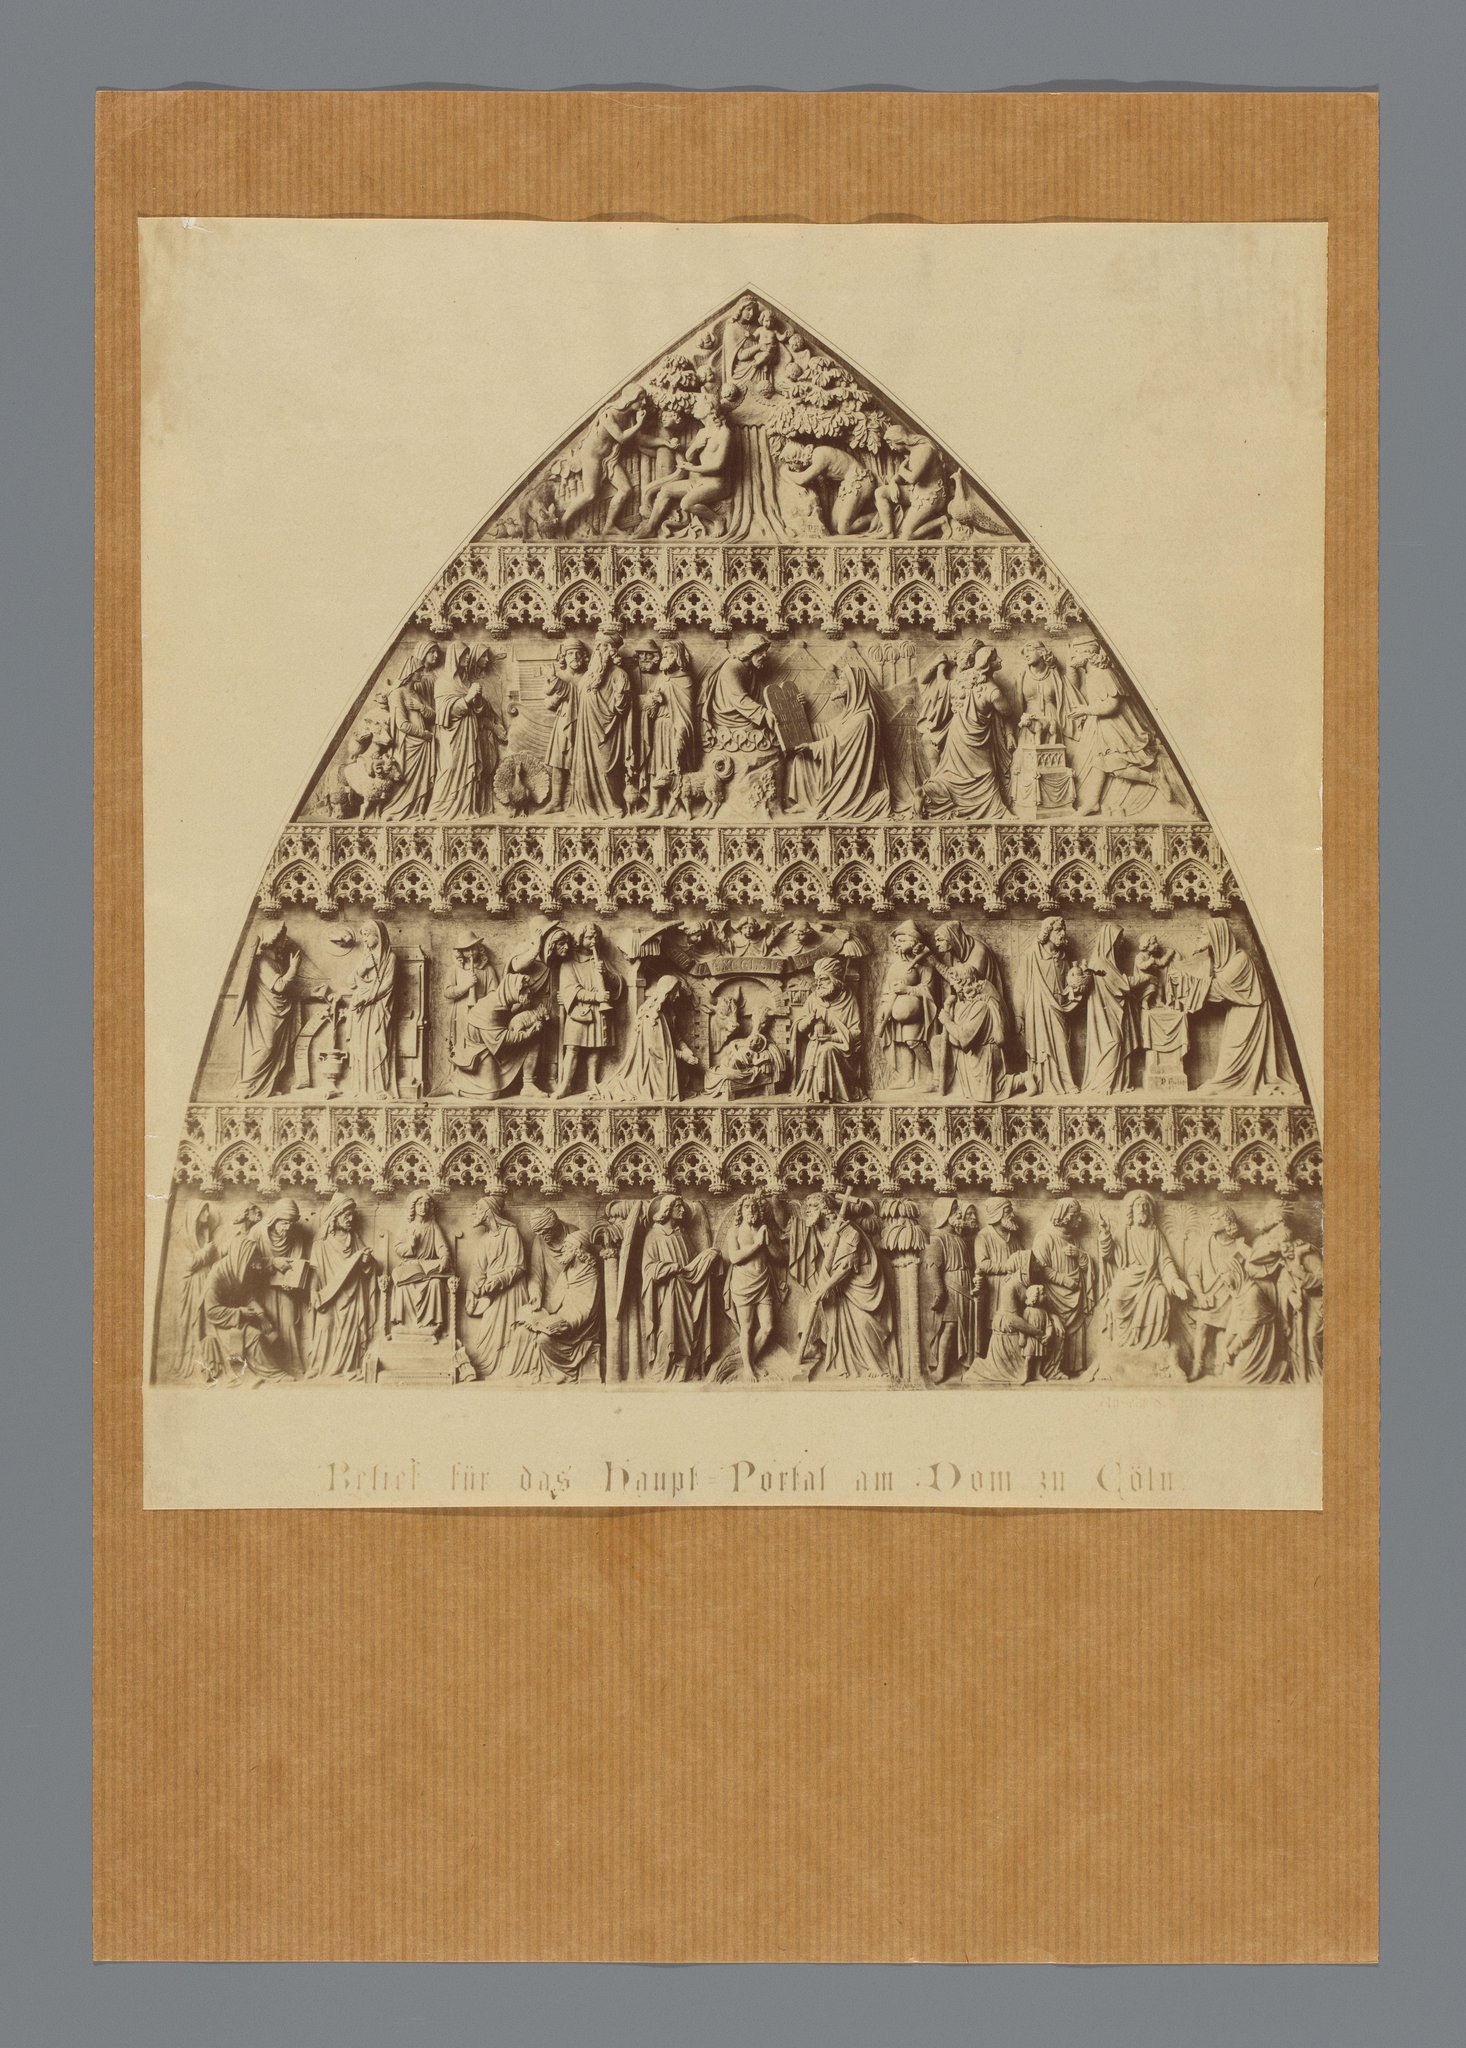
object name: photograph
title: Köln. Dom.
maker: Anonymous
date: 1850-1900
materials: photographic support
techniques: albumen print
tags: dom van keulen